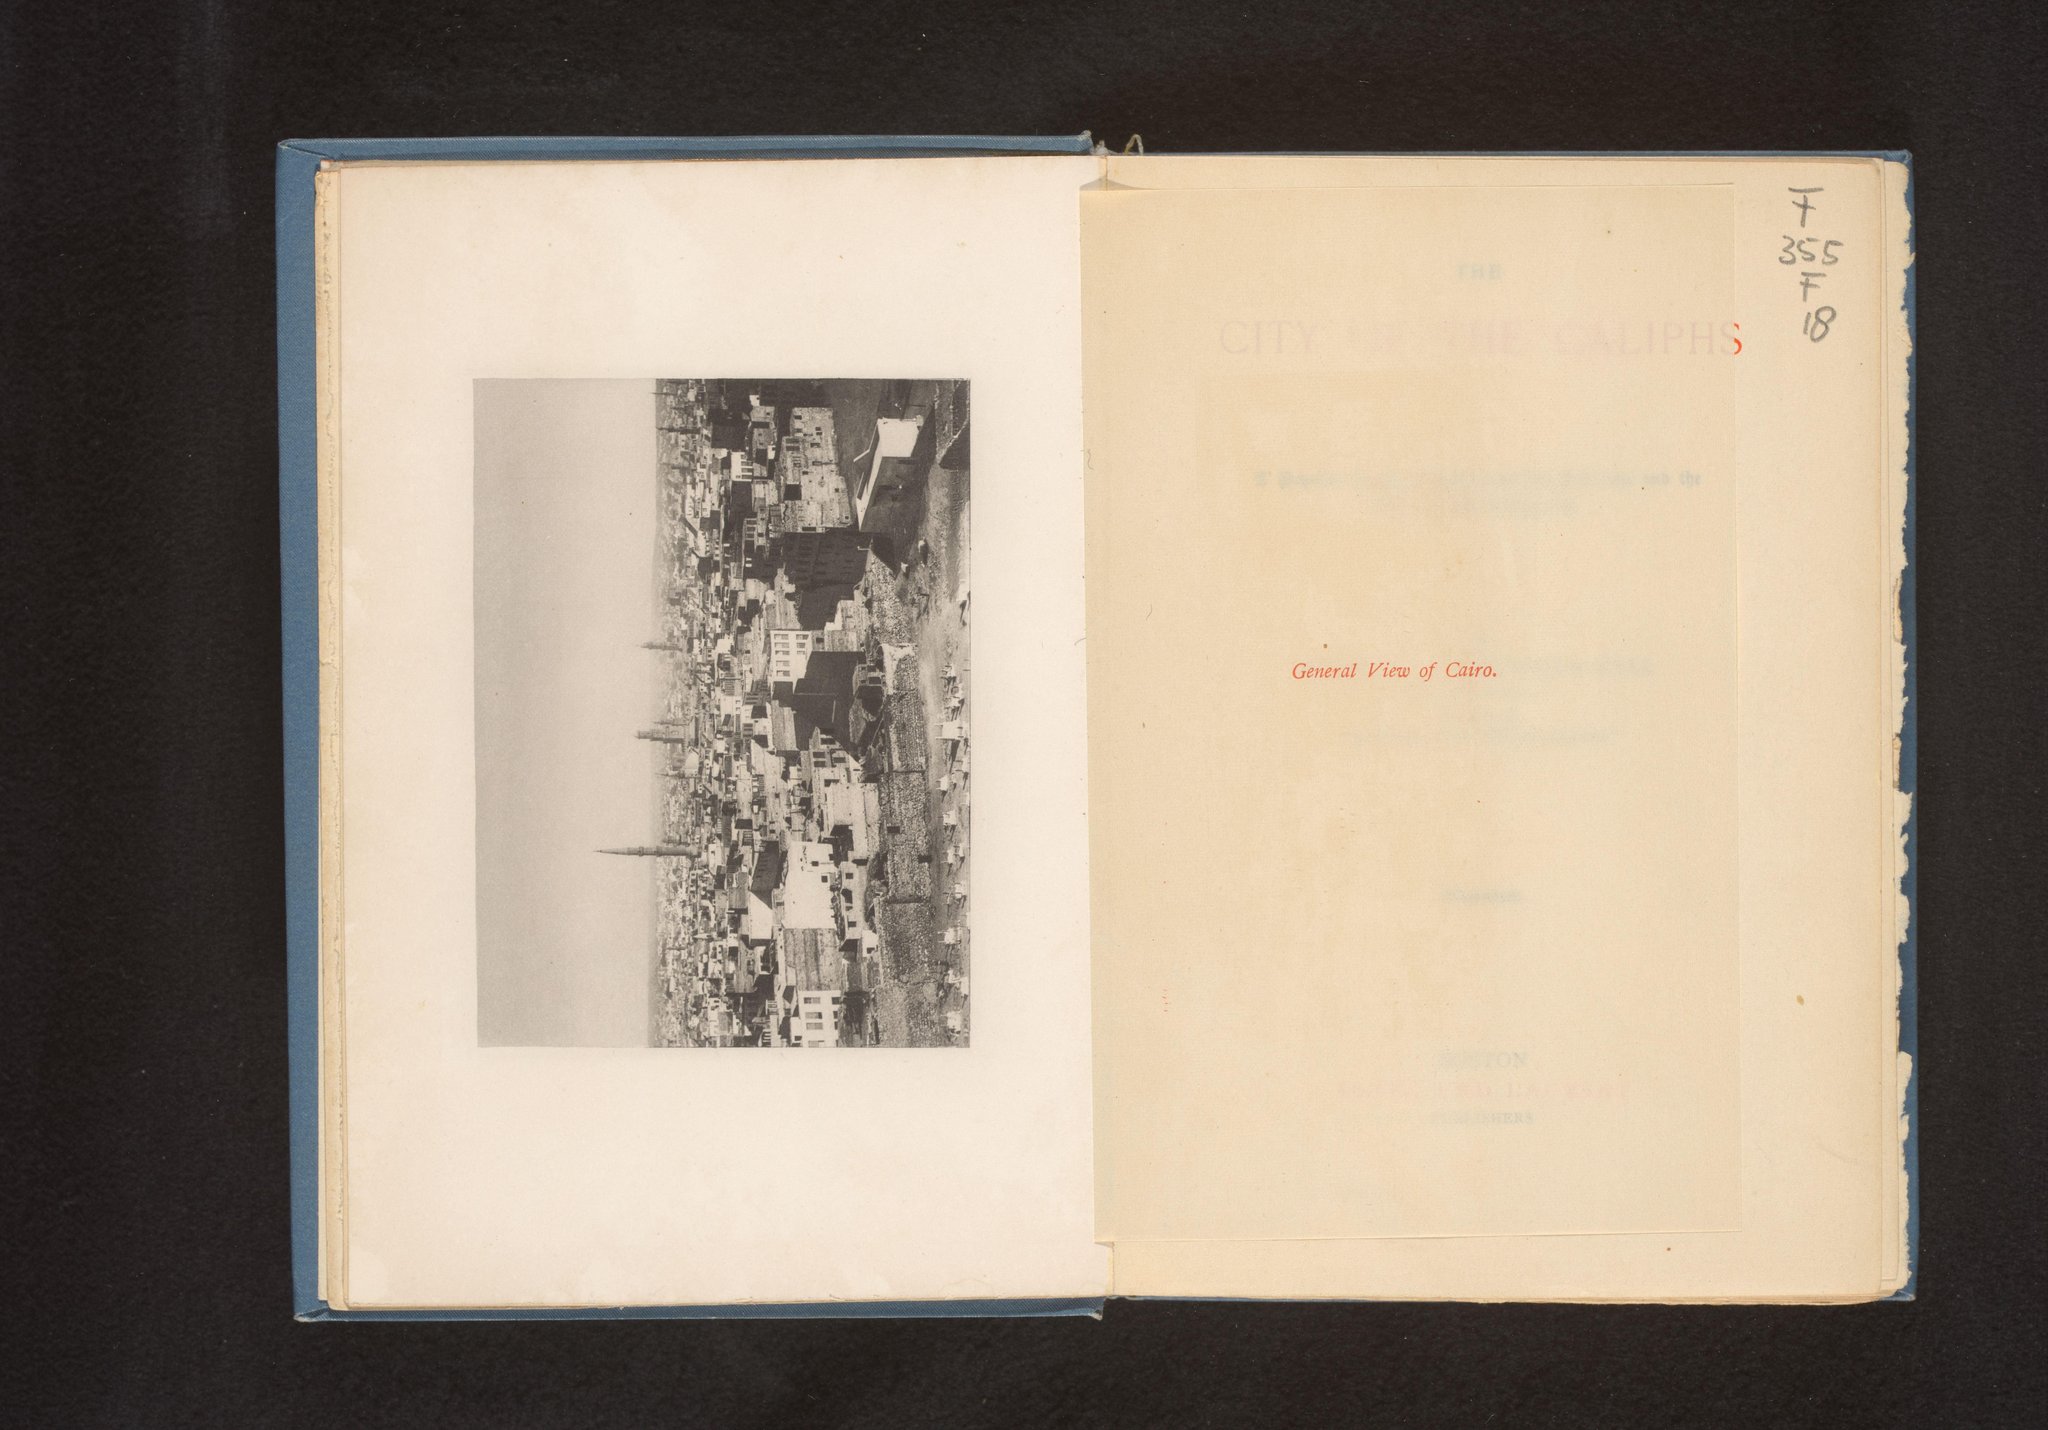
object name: photomechanical print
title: Gezicht op Caïro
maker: Anonymous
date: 1887-1897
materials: paper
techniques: photoaquatint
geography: cairo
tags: city-view in general; 'veduta'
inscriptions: title: ‘General View of Cairo.’